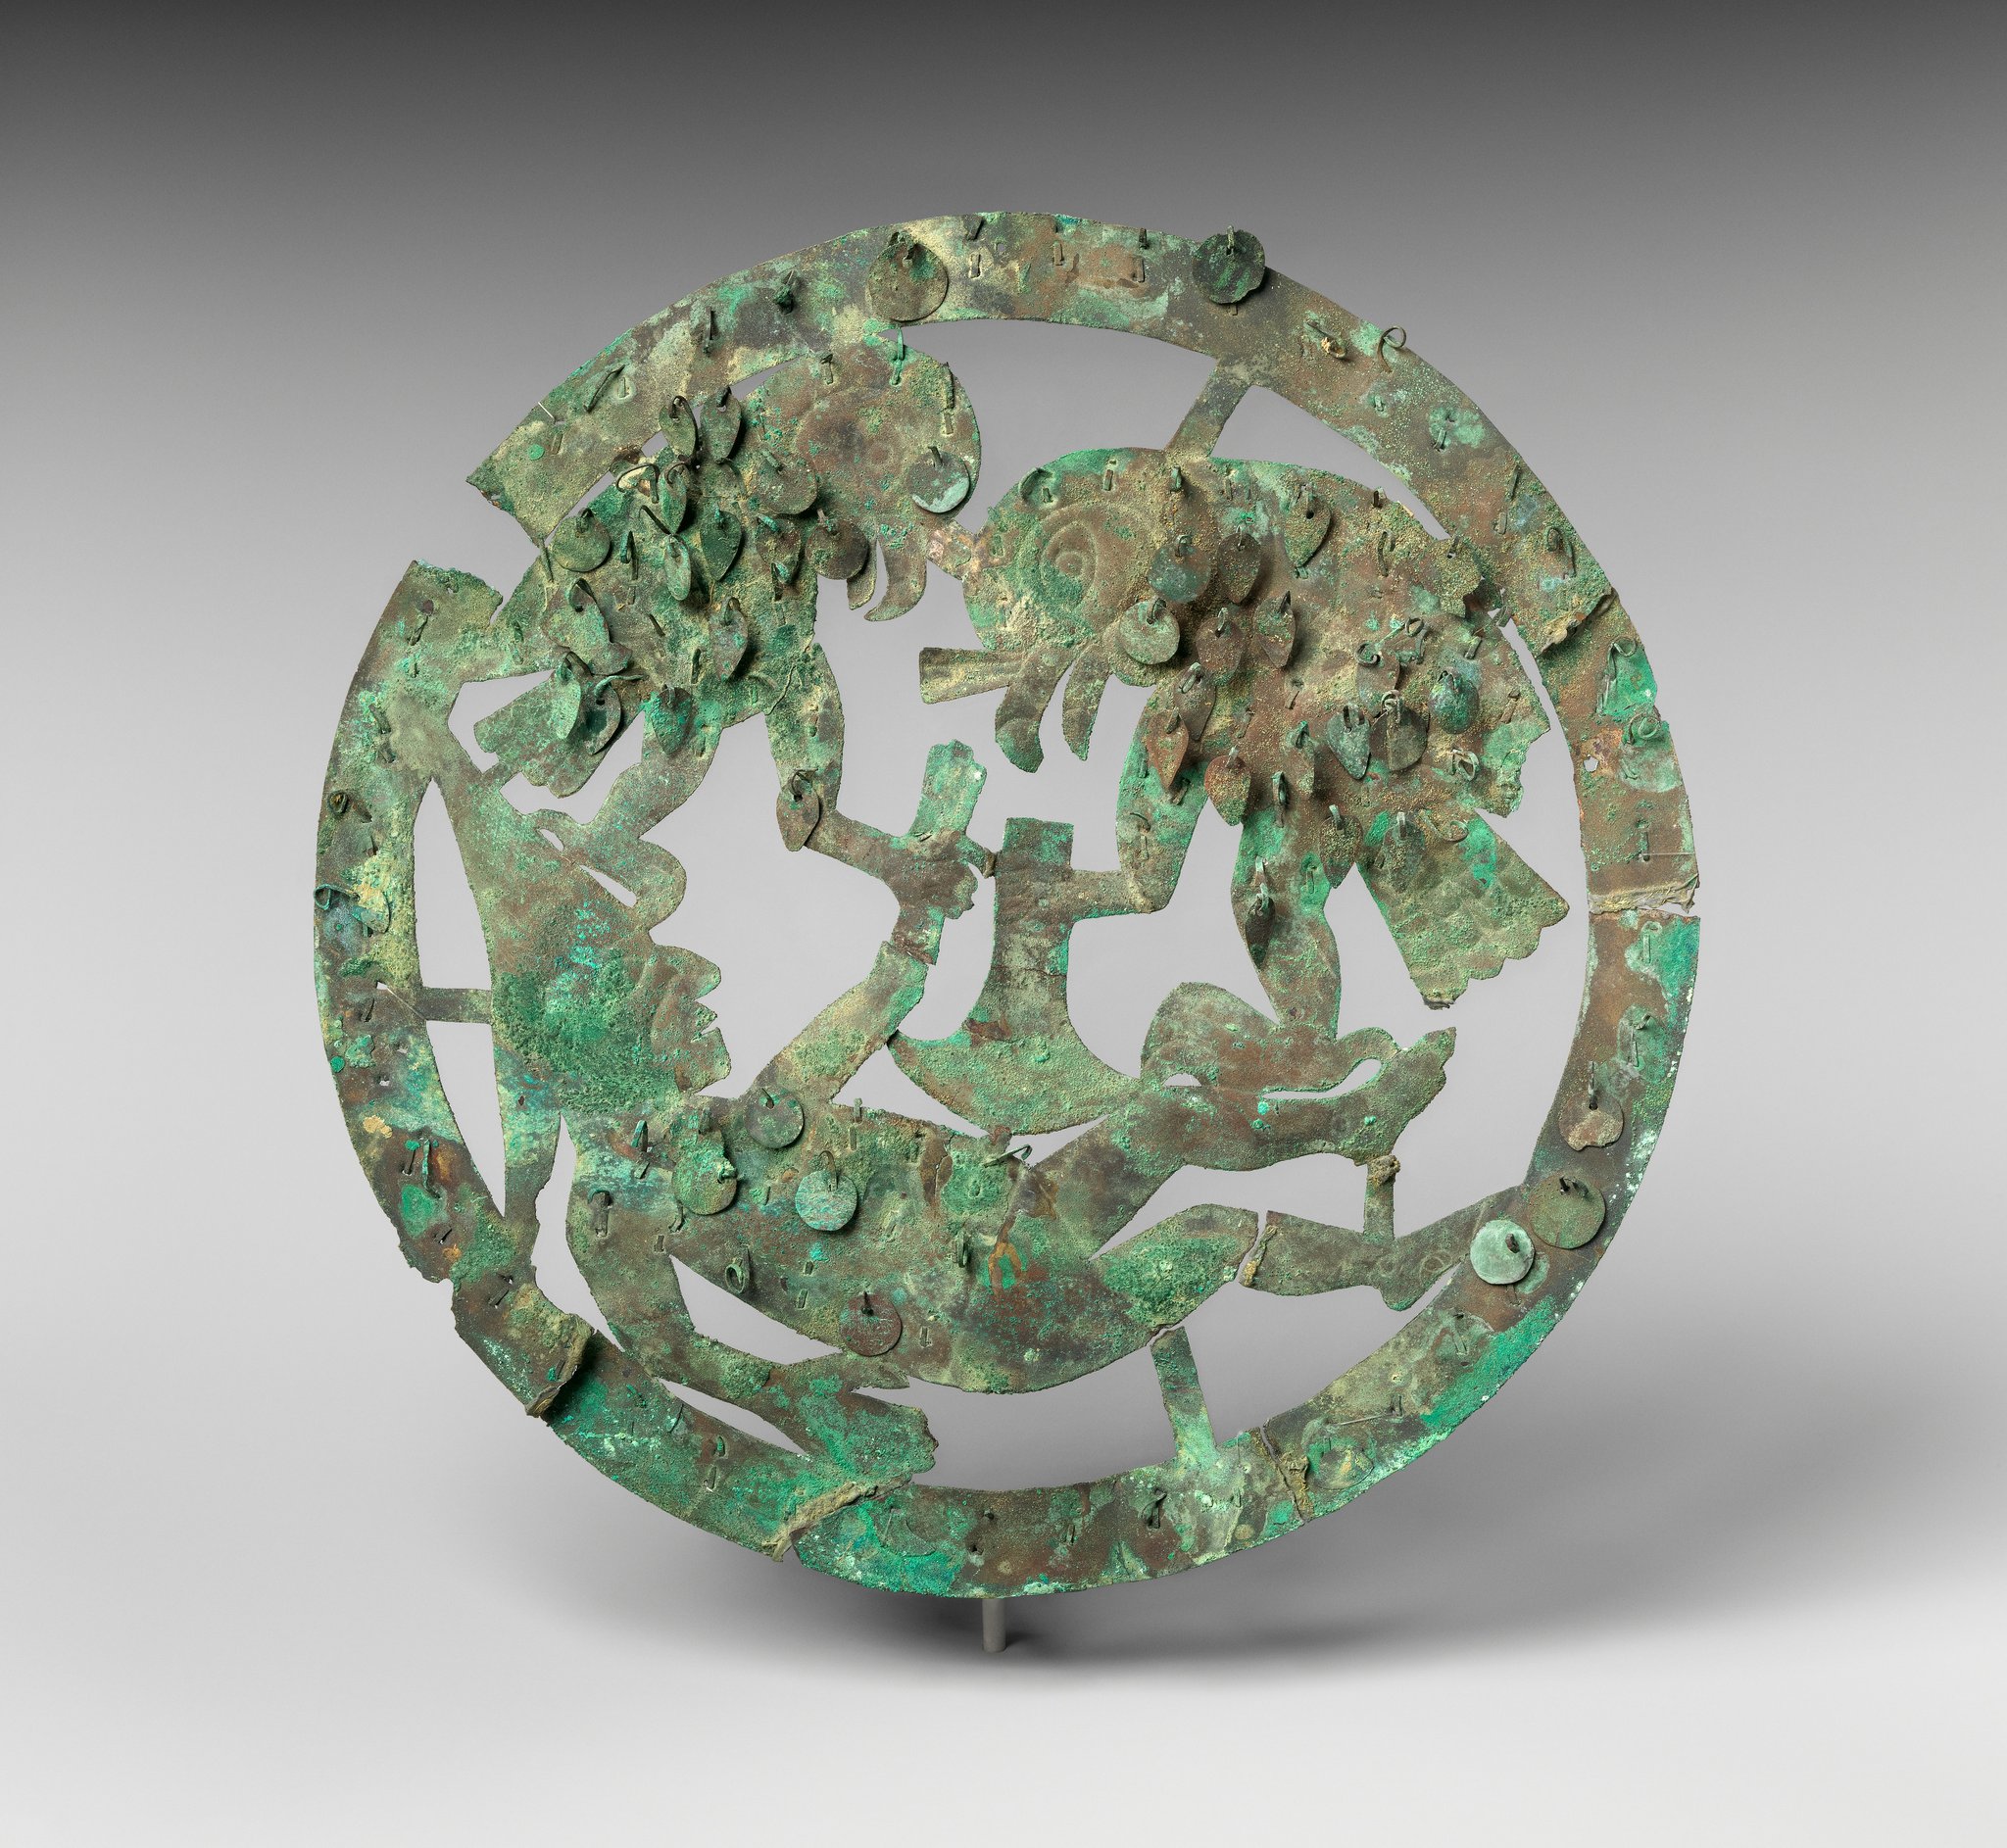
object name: ornament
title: Shield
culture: moche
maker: moche artist(s)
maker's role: artist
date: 500-800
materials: metal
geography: peru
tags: birds,men